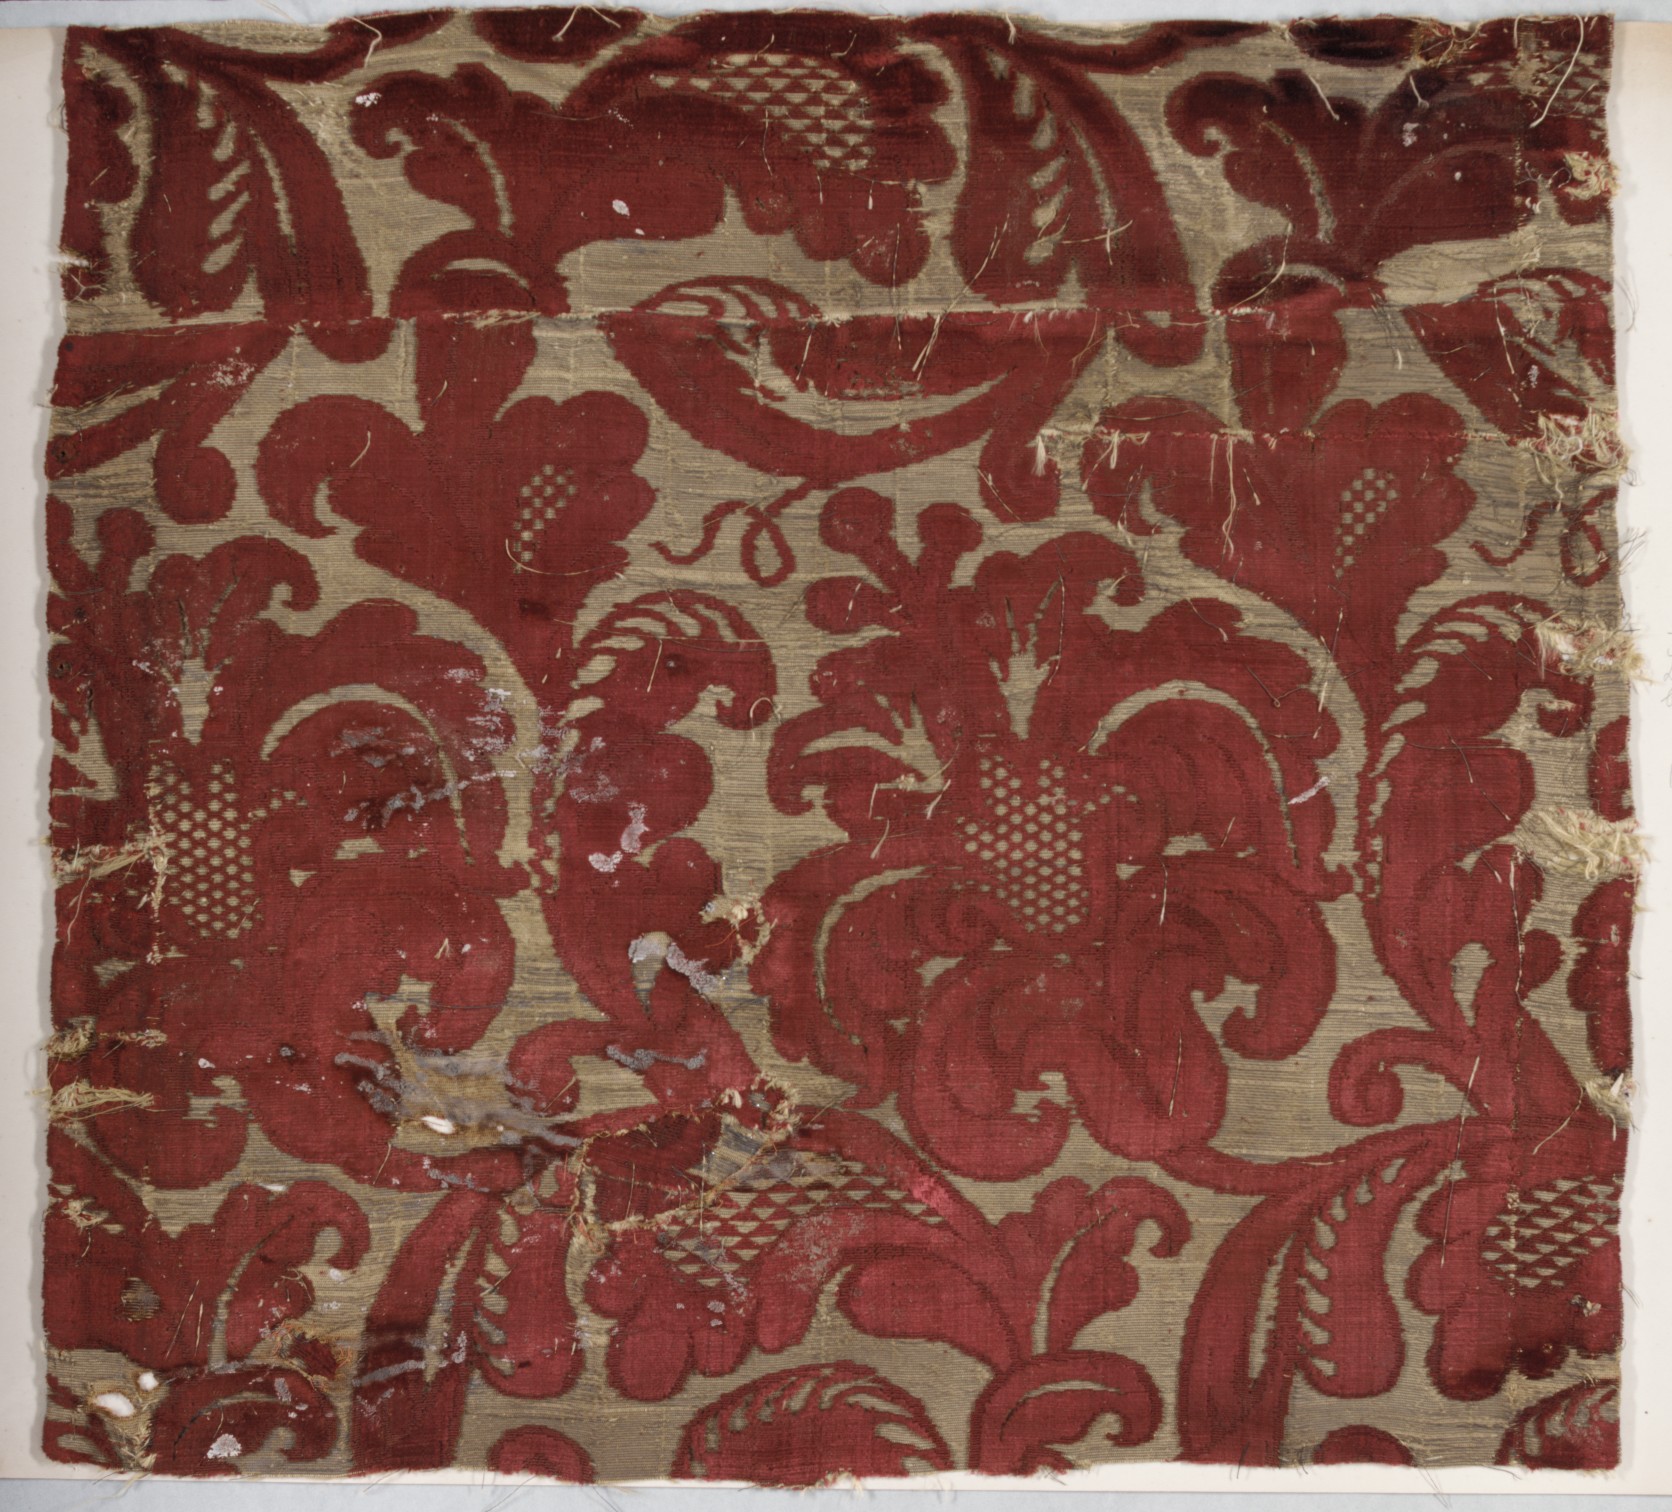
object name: fragment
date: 1667-1700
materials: metal thread, silk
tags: flowers